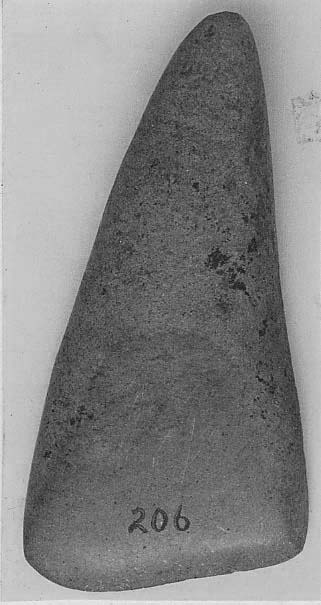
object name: knife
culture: french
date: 1902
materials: jade